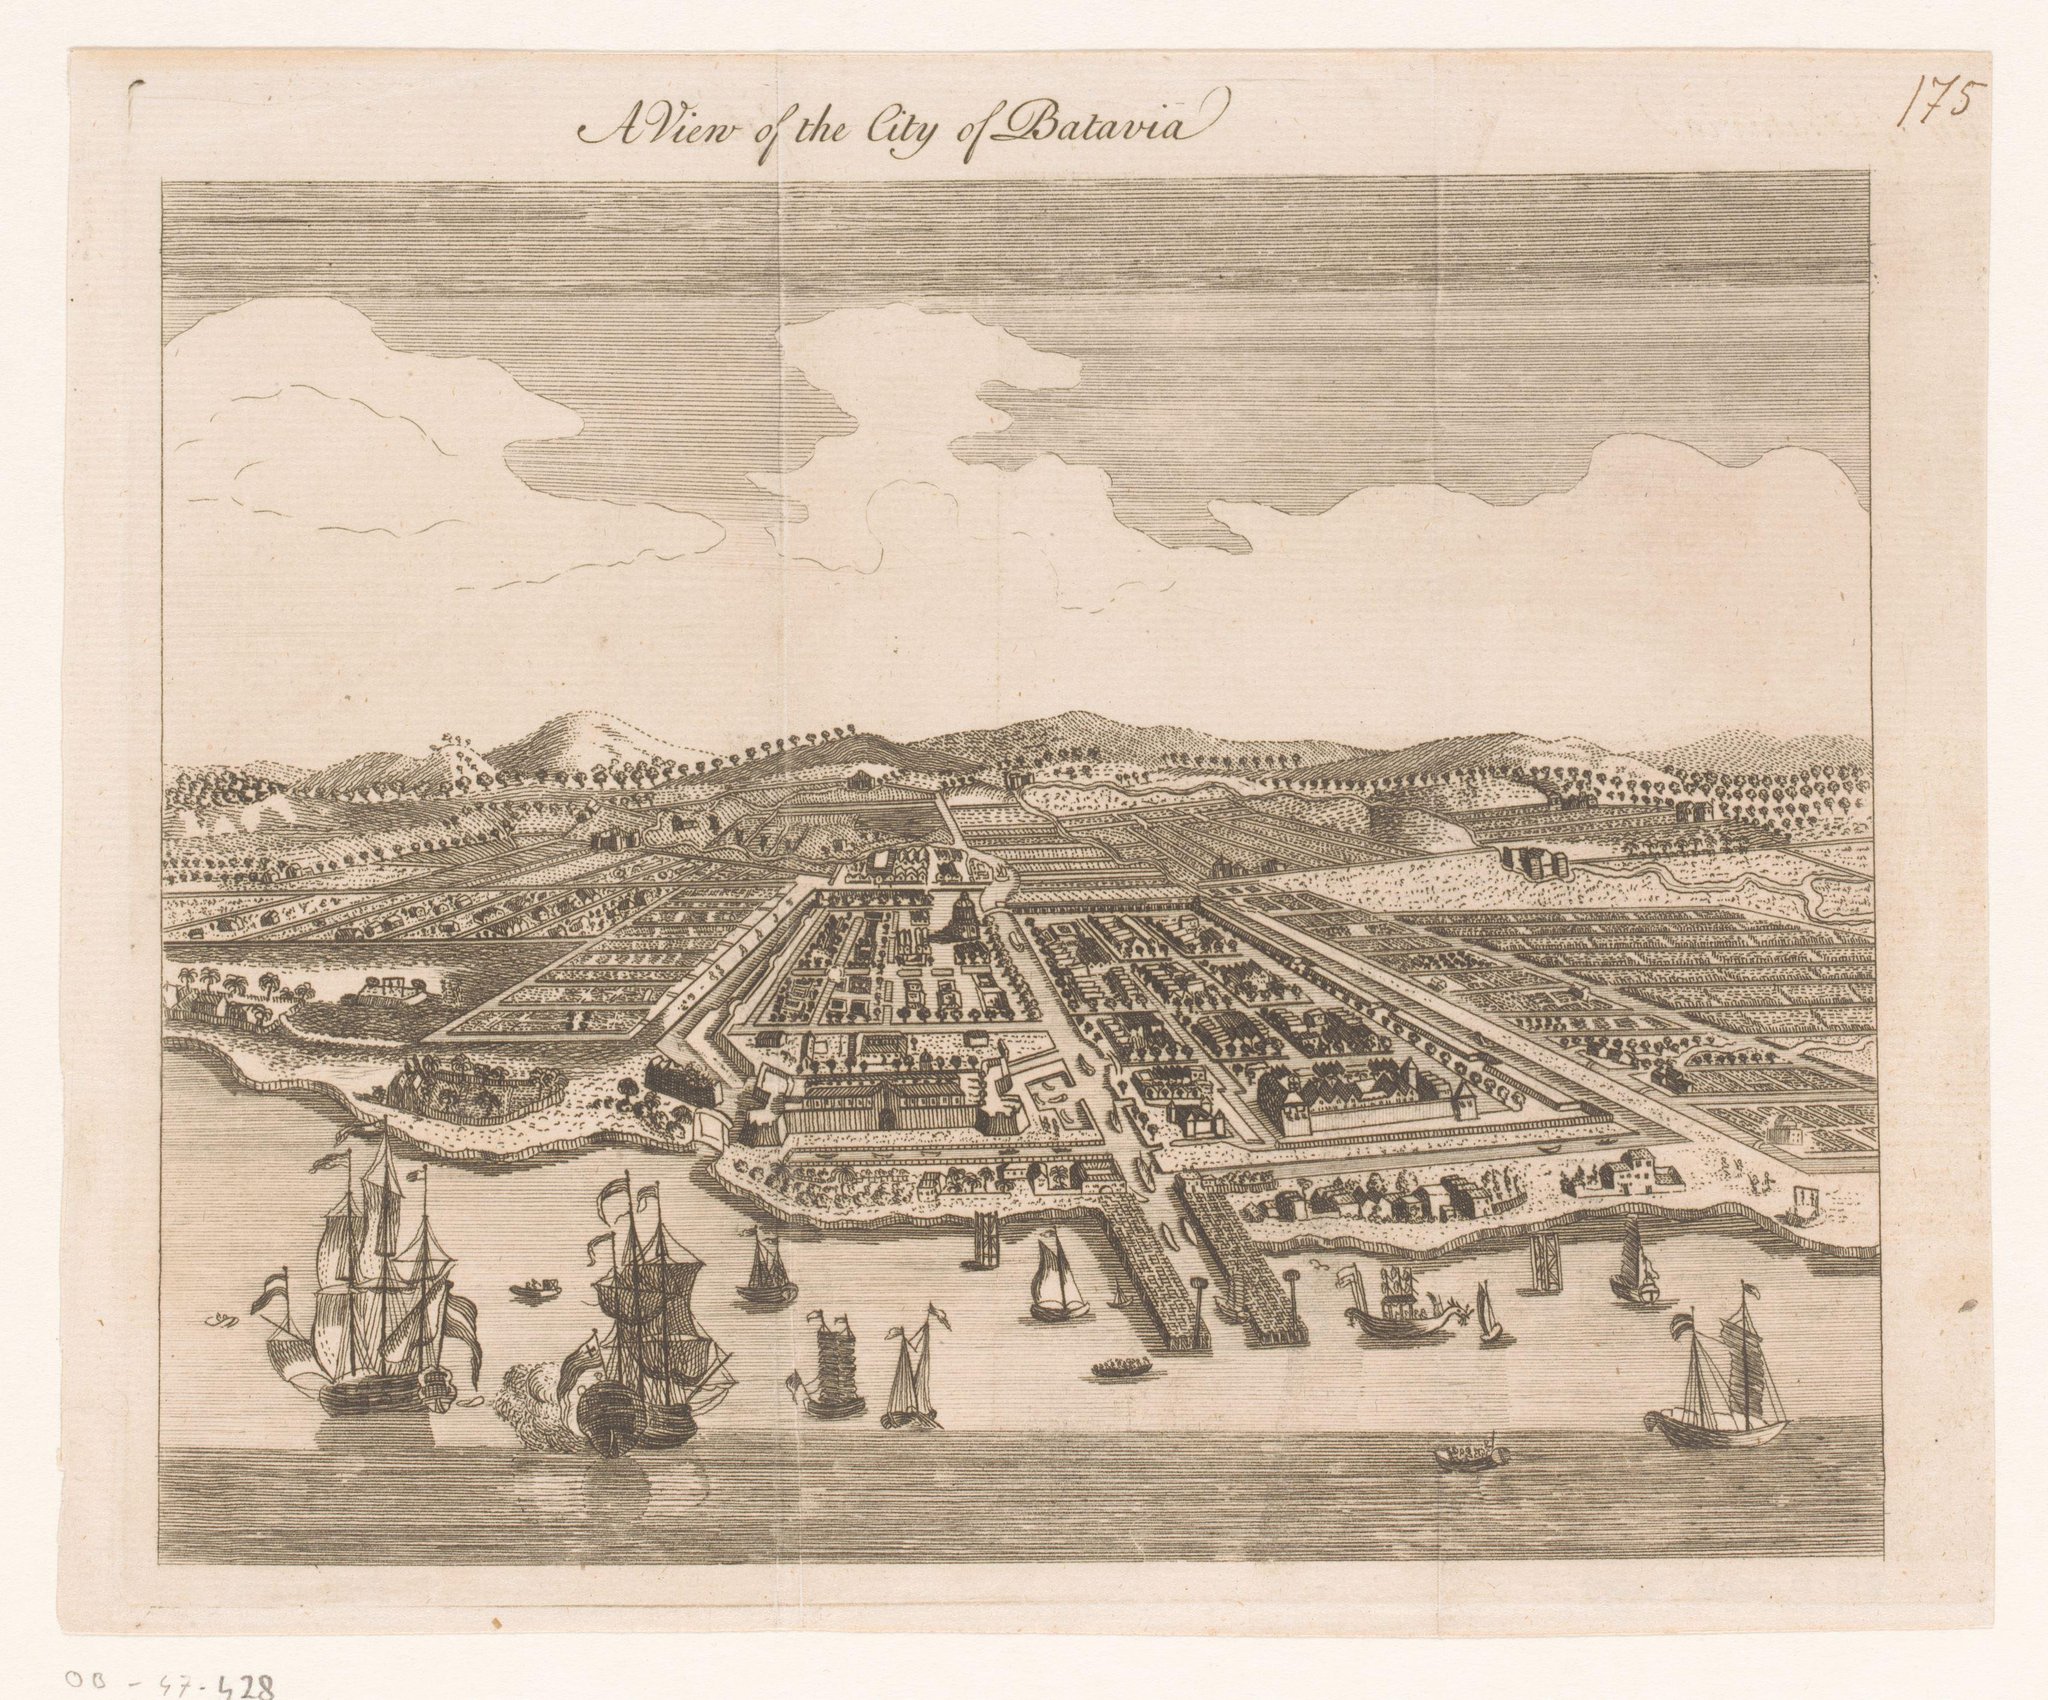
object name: print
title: Gezicht in vogelvluchtperspectief op Batavia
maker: Anonymous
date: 1762-1800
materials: paper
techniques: engraving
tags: island (in tropical and sub-tropical regions), ship in the roads, roadstead, batavia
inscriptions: collector's mark: Lugt 2228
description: Mogelijk kopie naar prent uitgegeven in: Noble, C.F.. A Voyage to the East Indies in 1747 and 1748 (...). Londen: printed for T. Becket, P.A. Dehondt & T. Durham, 1762, p. 77.